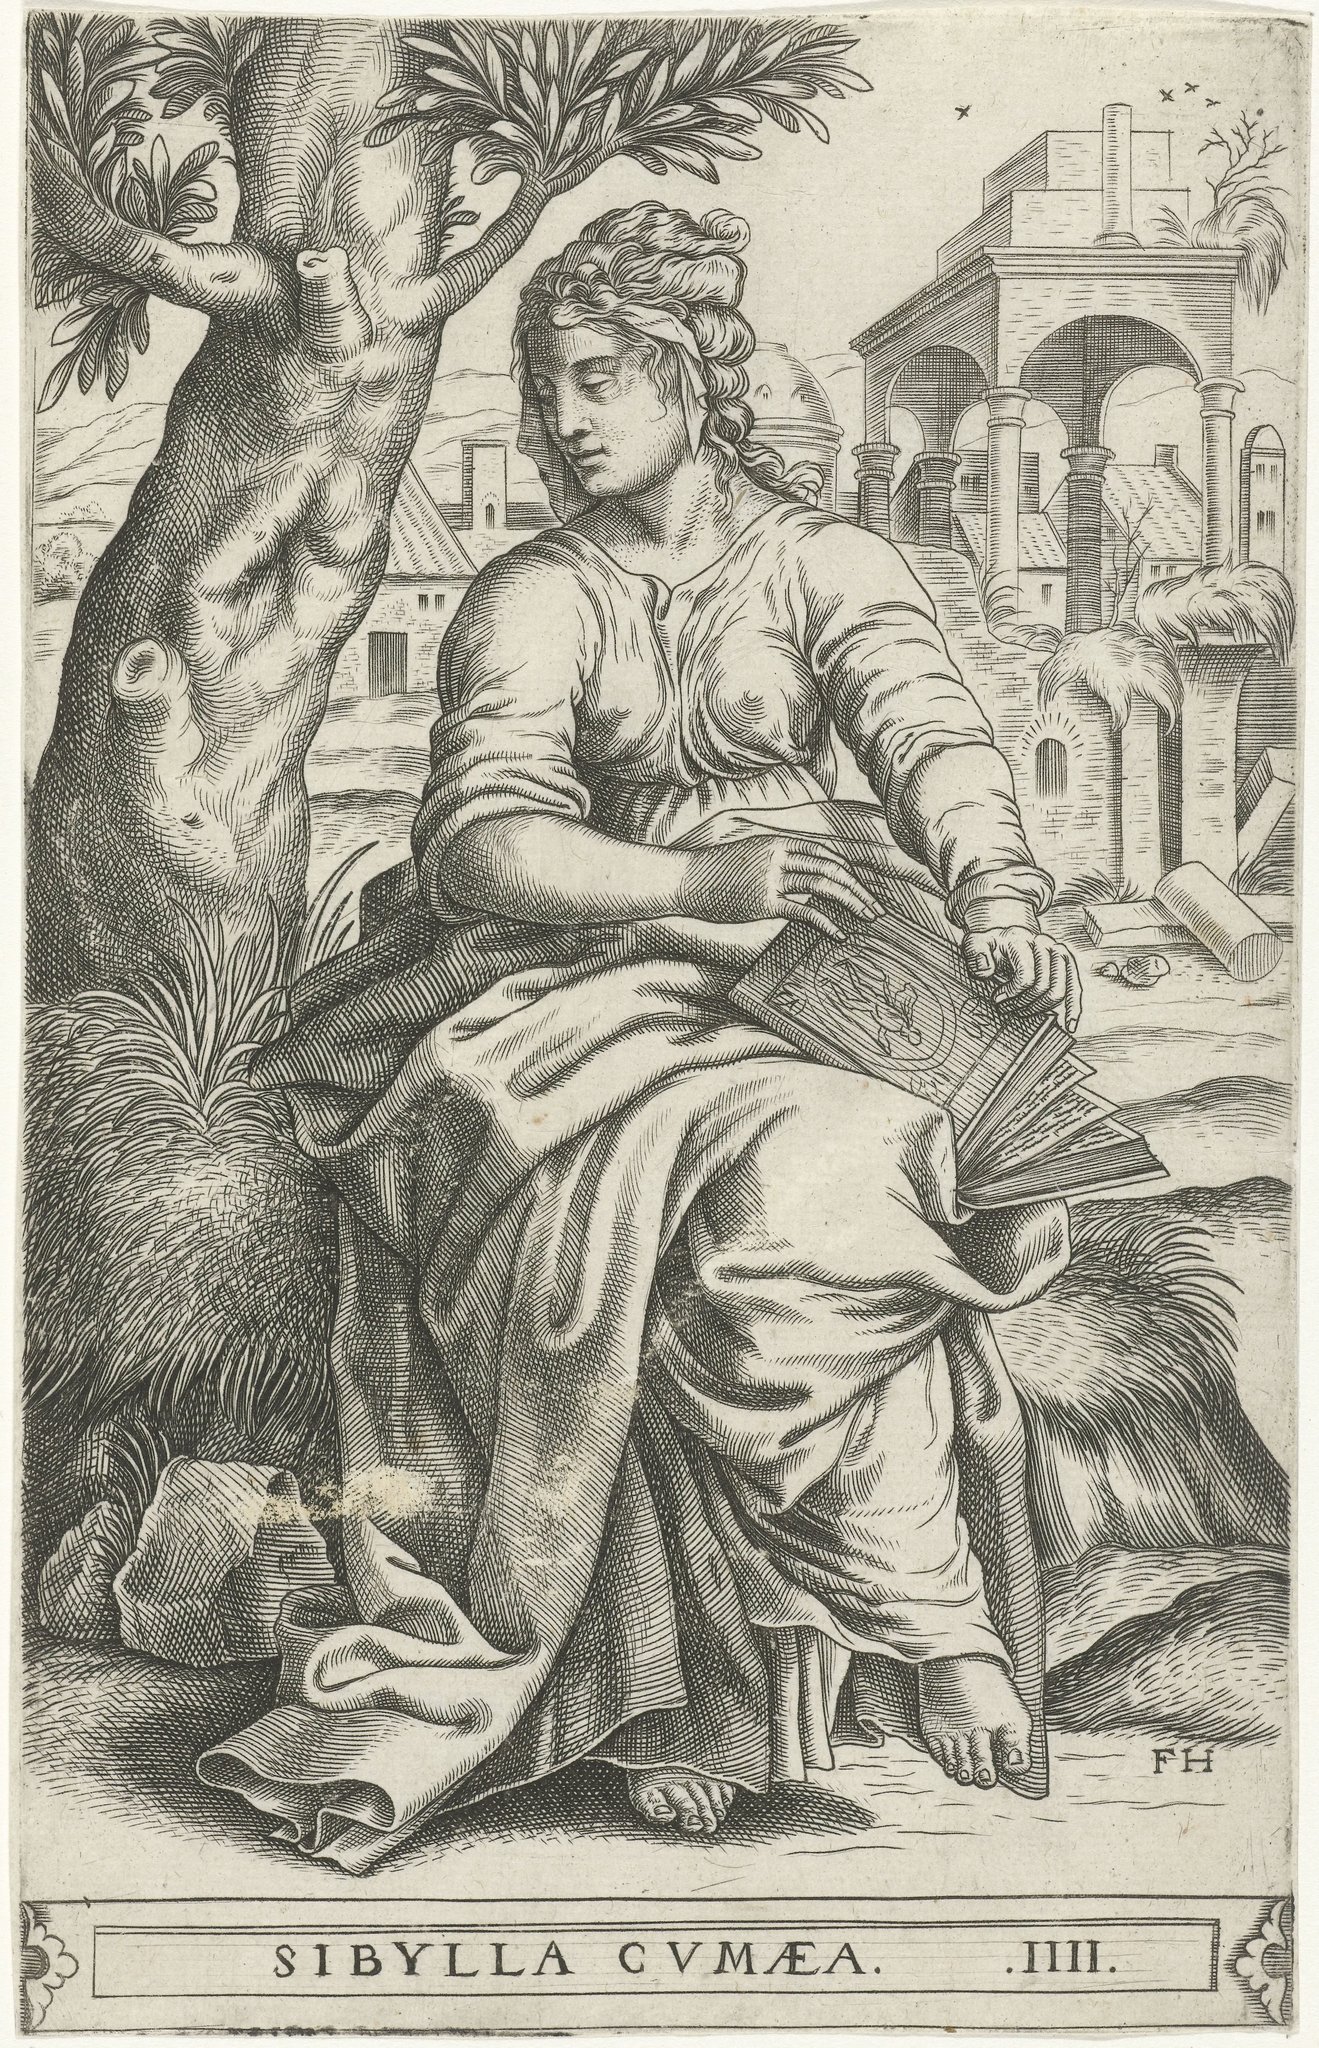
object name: print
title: Sibille van Cumae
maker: frans huys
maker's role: print maker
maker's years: 1522-1562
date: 1546-1562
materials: paper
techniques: engraving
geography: antwerp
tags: cumaean sibyl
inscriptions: collector's mark: Lugt 2228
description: De Sibille van Cumae met een boek op haar schoot, zittend onder een boom. Op de achtergrond een stad in een landschap. De prent maakt deel uit van een tiendelige serie over de Sibillen.